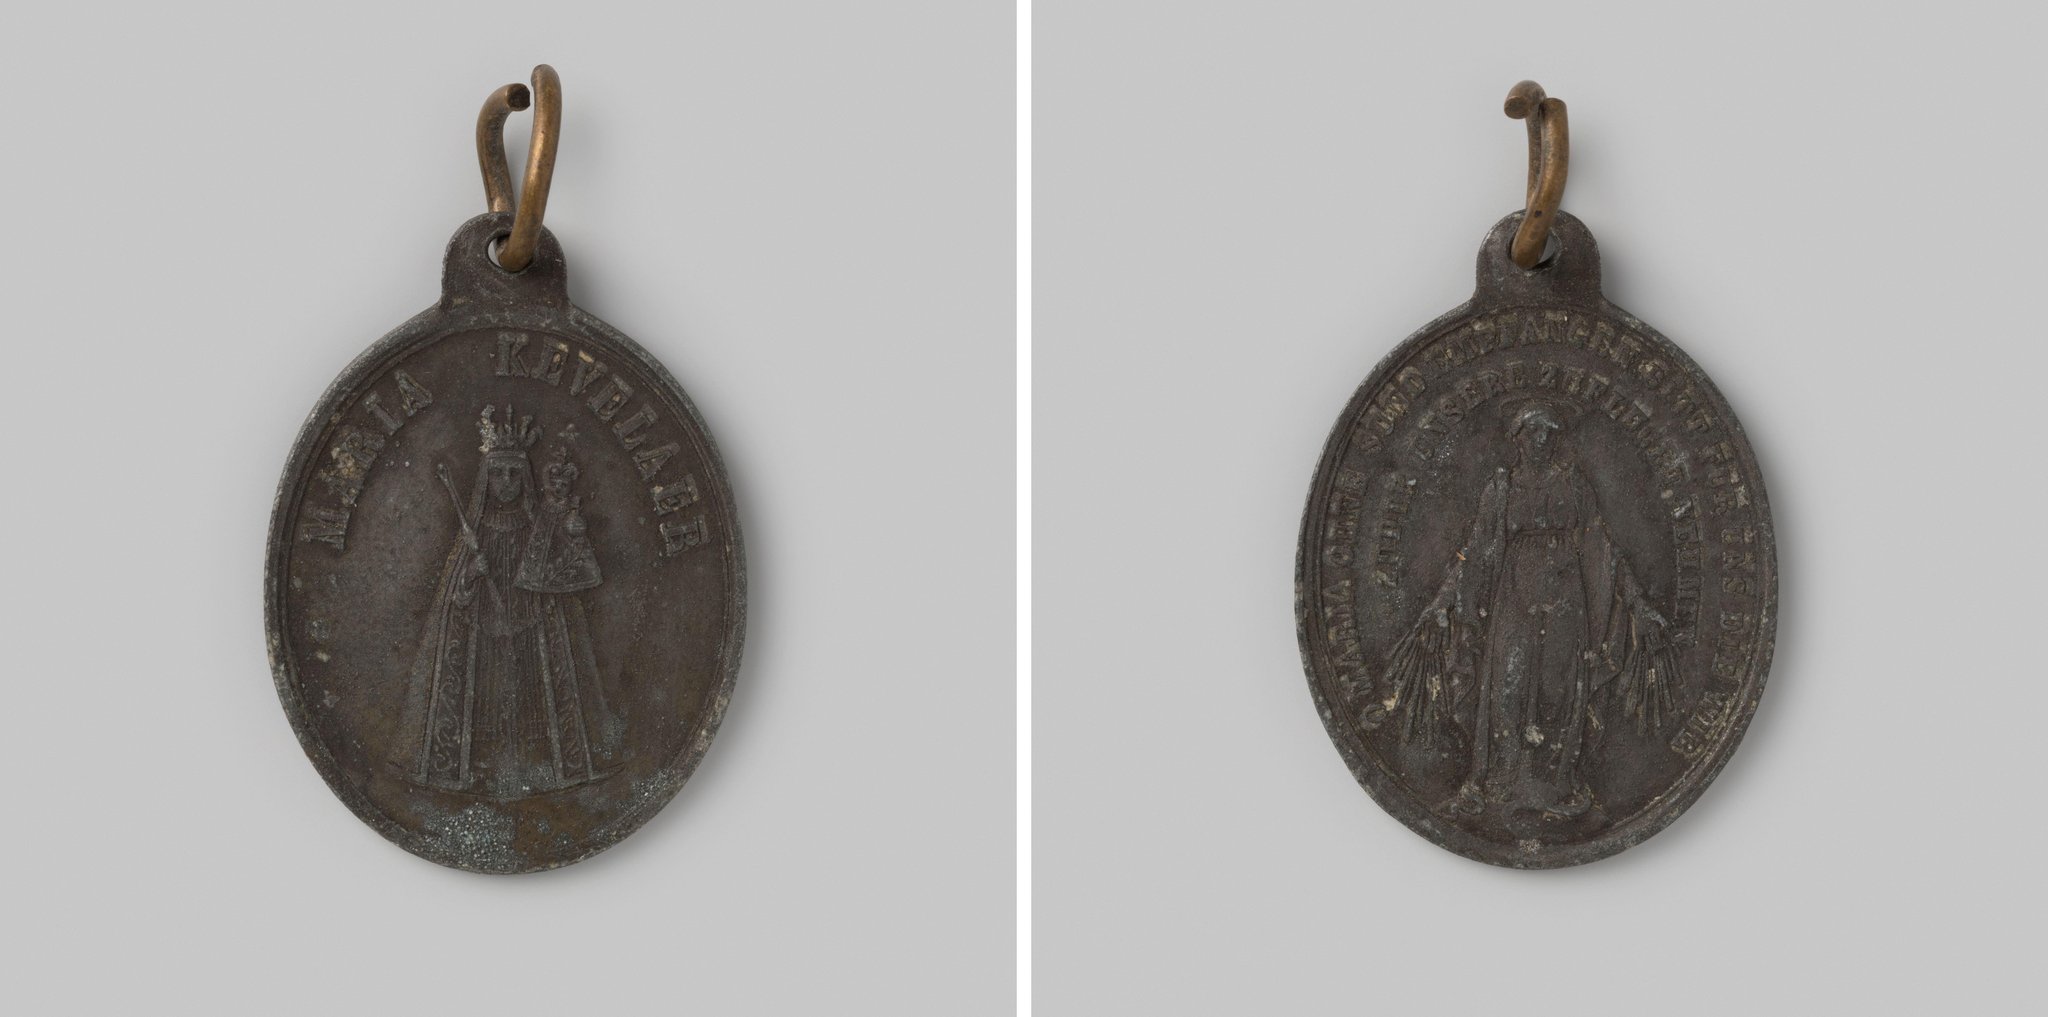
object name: history medal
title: Religieus draagteken met Maria van Kevalaer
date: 1800-1850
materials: zinc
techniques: casting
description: Ovalen zinkkleurige penning met oog en draagring, op de voorzijde Maria van Kevelaer met omschrift, op de keerzijde Maria met dubbel omschrift.